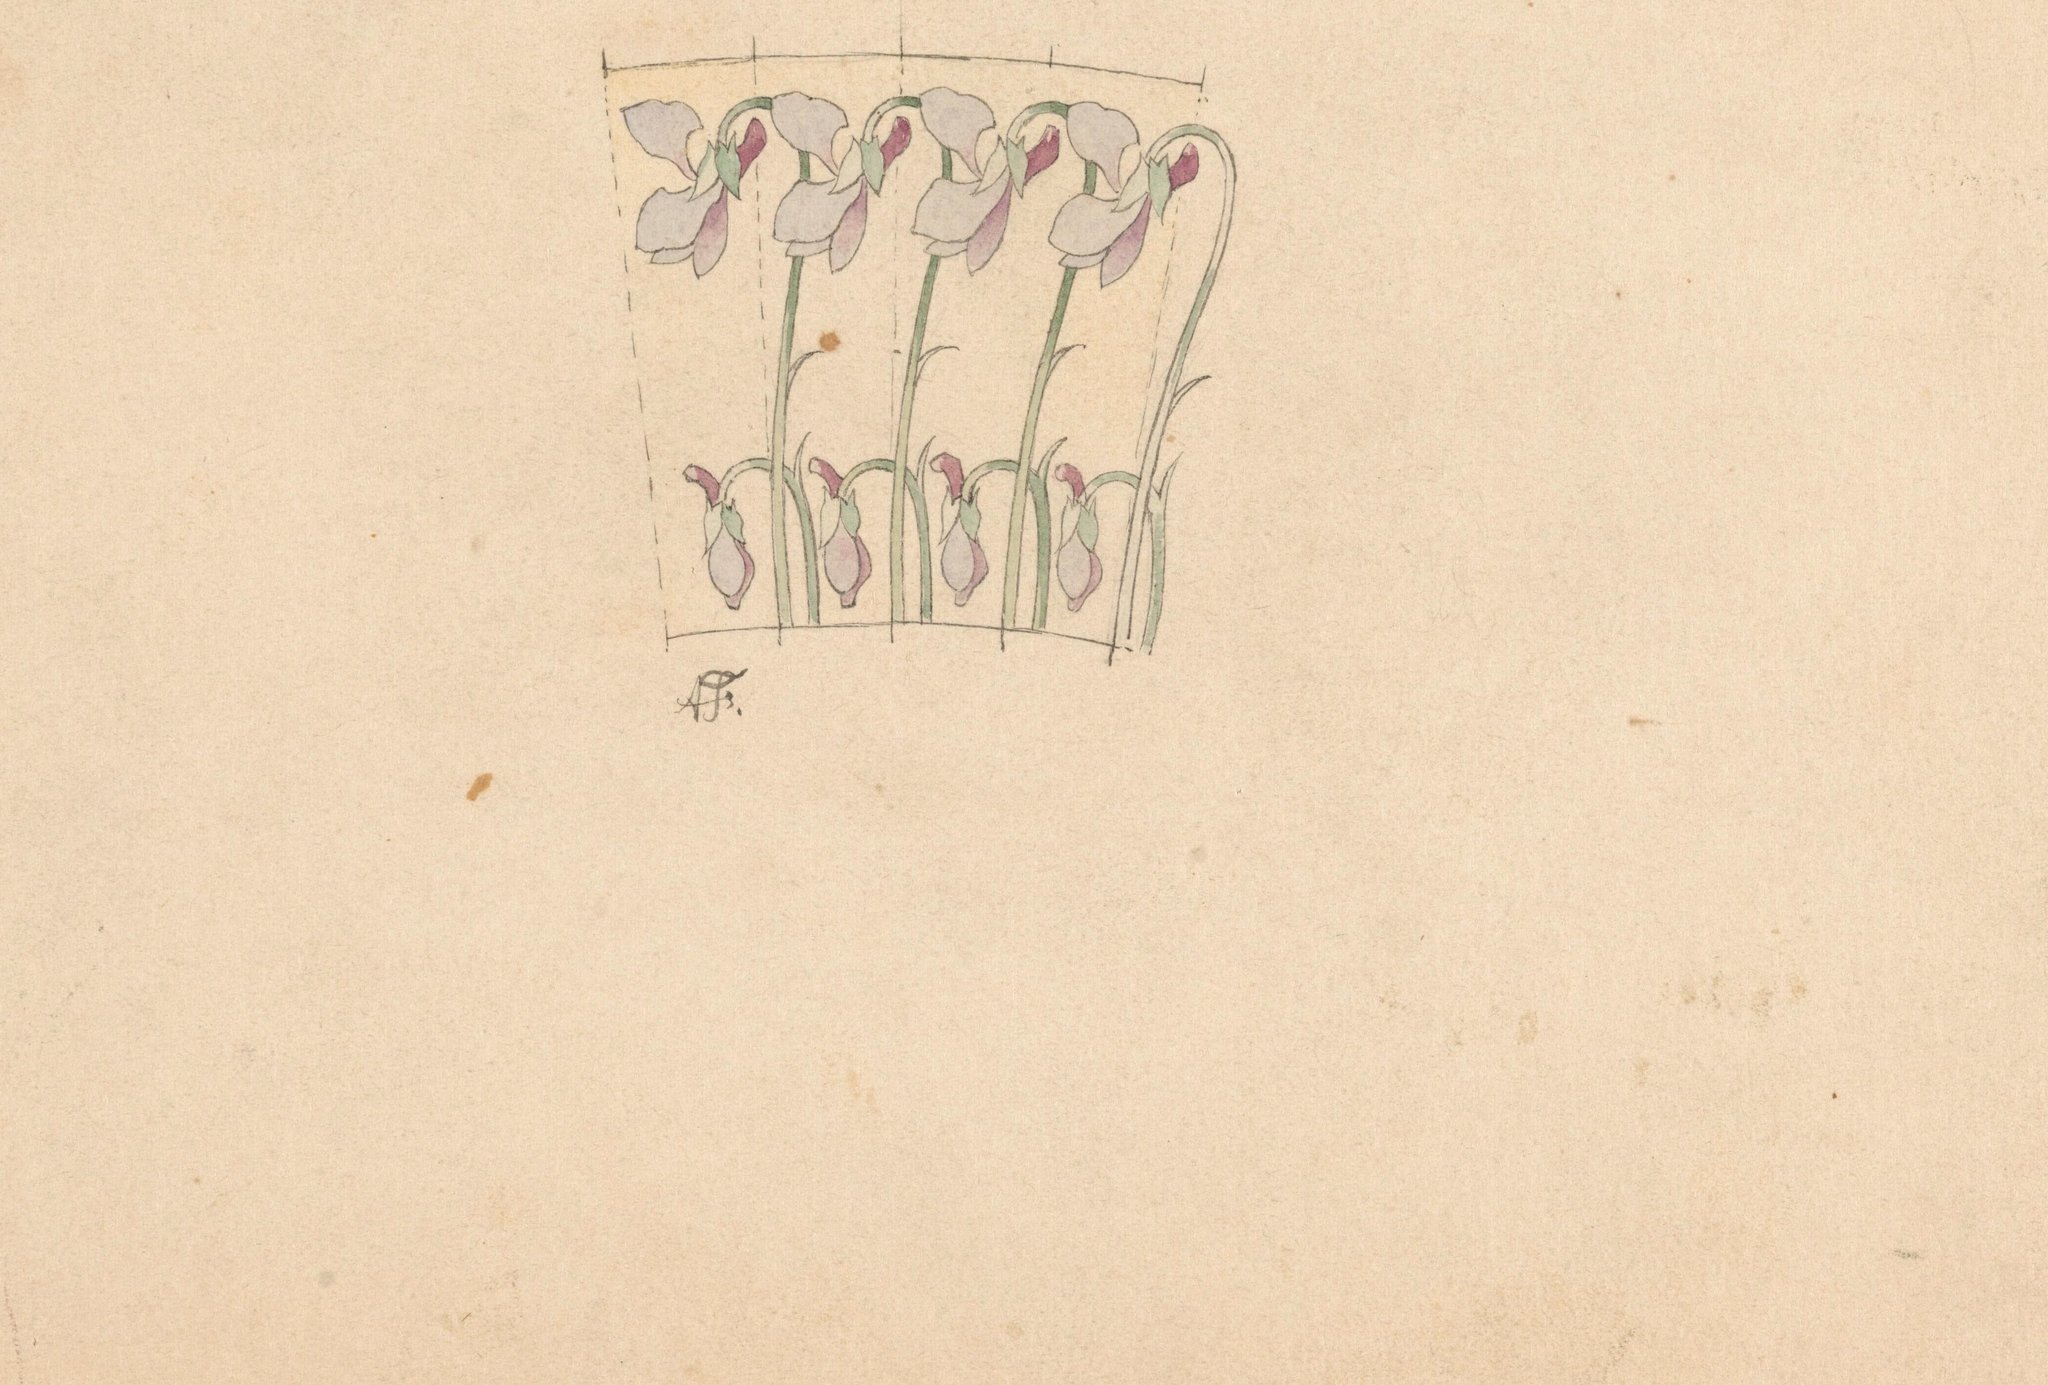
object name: design drawing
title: Vijf segmenten van een met viooltjes beschilderde knop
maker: anatole-alexis fournier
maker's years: 1864-1926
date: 1897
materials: graphite, ink, paper, watercolor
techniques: aquarelle, pen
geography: sèvres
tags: flowers: violet, flowers ~ ornament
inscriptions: inscription: ‘mauvais’, inscription: ‘Divisions en 6’, inscription: ‘Bouchon droit. / Violettes’, signature: ‘AF’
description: Daarboven een rond medaillon met een spiegelmonogram van de letters PP.